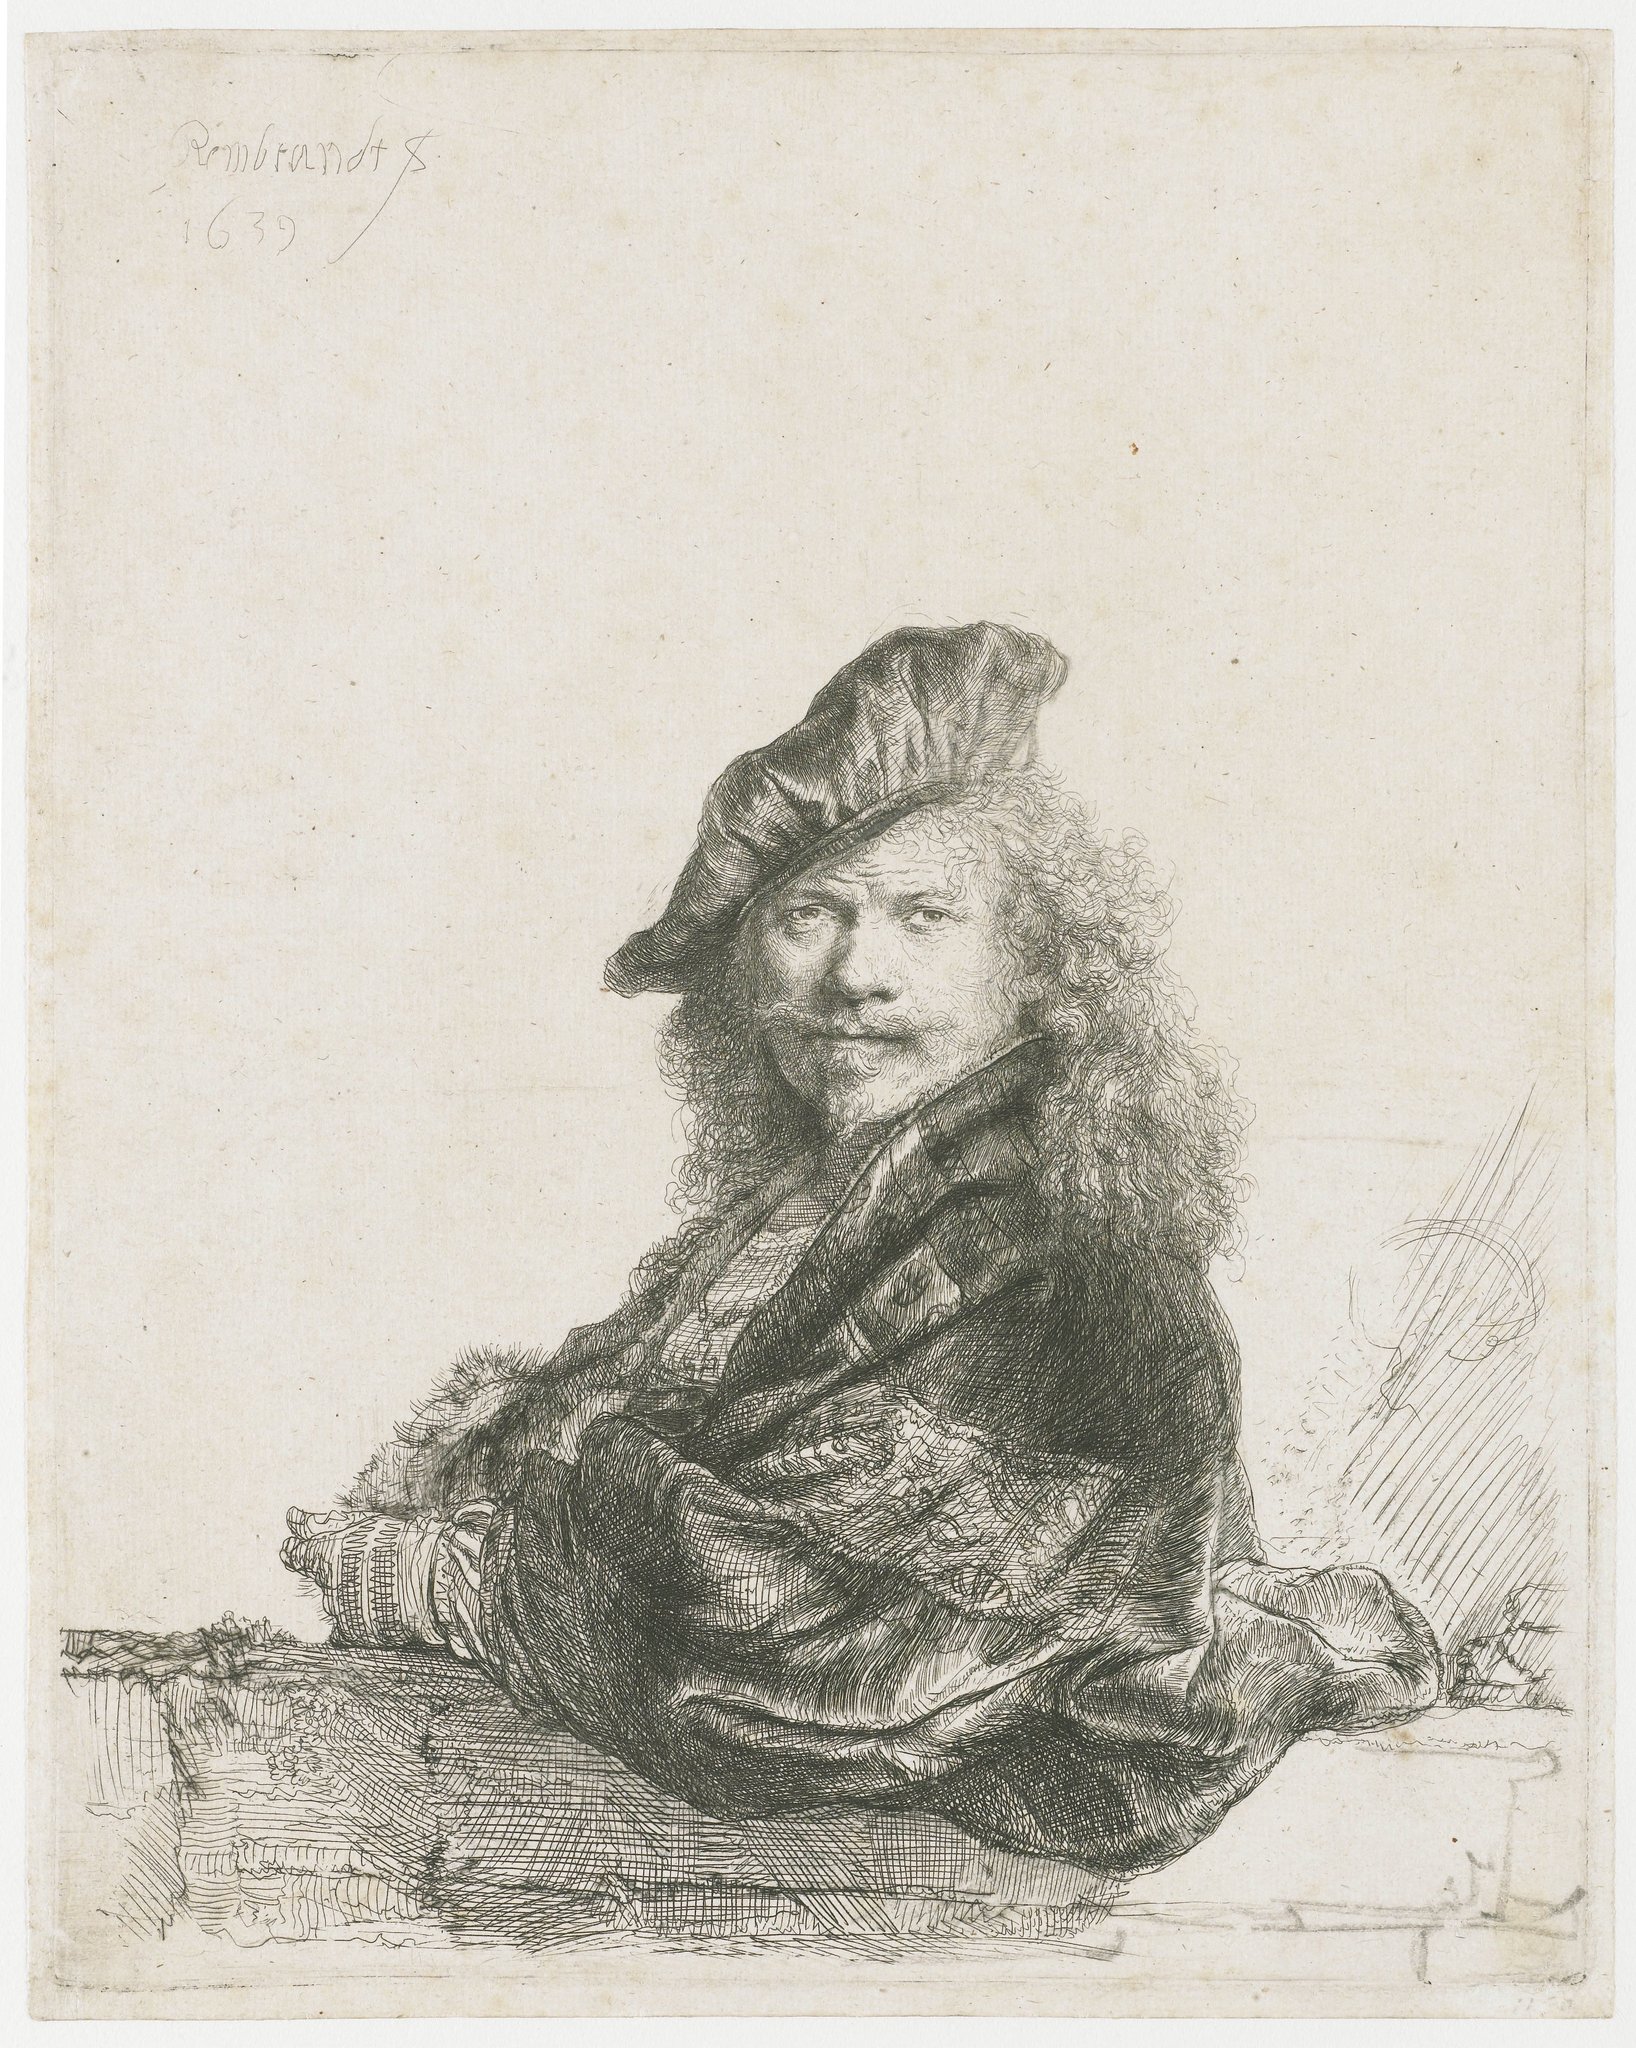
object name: print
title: Self-portrait leaning on a stone sill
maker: rembrandt van rijn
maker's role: draughtsman, painter, print maker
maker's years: 1606-1669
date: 1639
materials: chalk, paper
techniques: drypoint, etching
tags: leiden, amsterdam, painter, print maker, draughtsman, rembrandt van rijn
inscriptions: collector's mark: Lugt 2925bis, signature and date: ‘Rembrandt f. 1639’, collector's mark: Lugt 573, collector's mark: Lugt 12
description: In his early self-portraits, Rembrandt often practises rendering light or emotions. By contrast, these later ones are more narrative, because he dresses up in imaginary costumes (e.g. complete with an Oriental sword) or in 16th-century attire. With the latter variant, he aligns himself with celebrated 16th-century artists, such as Lucas van Leyden, Titian or Raphael.